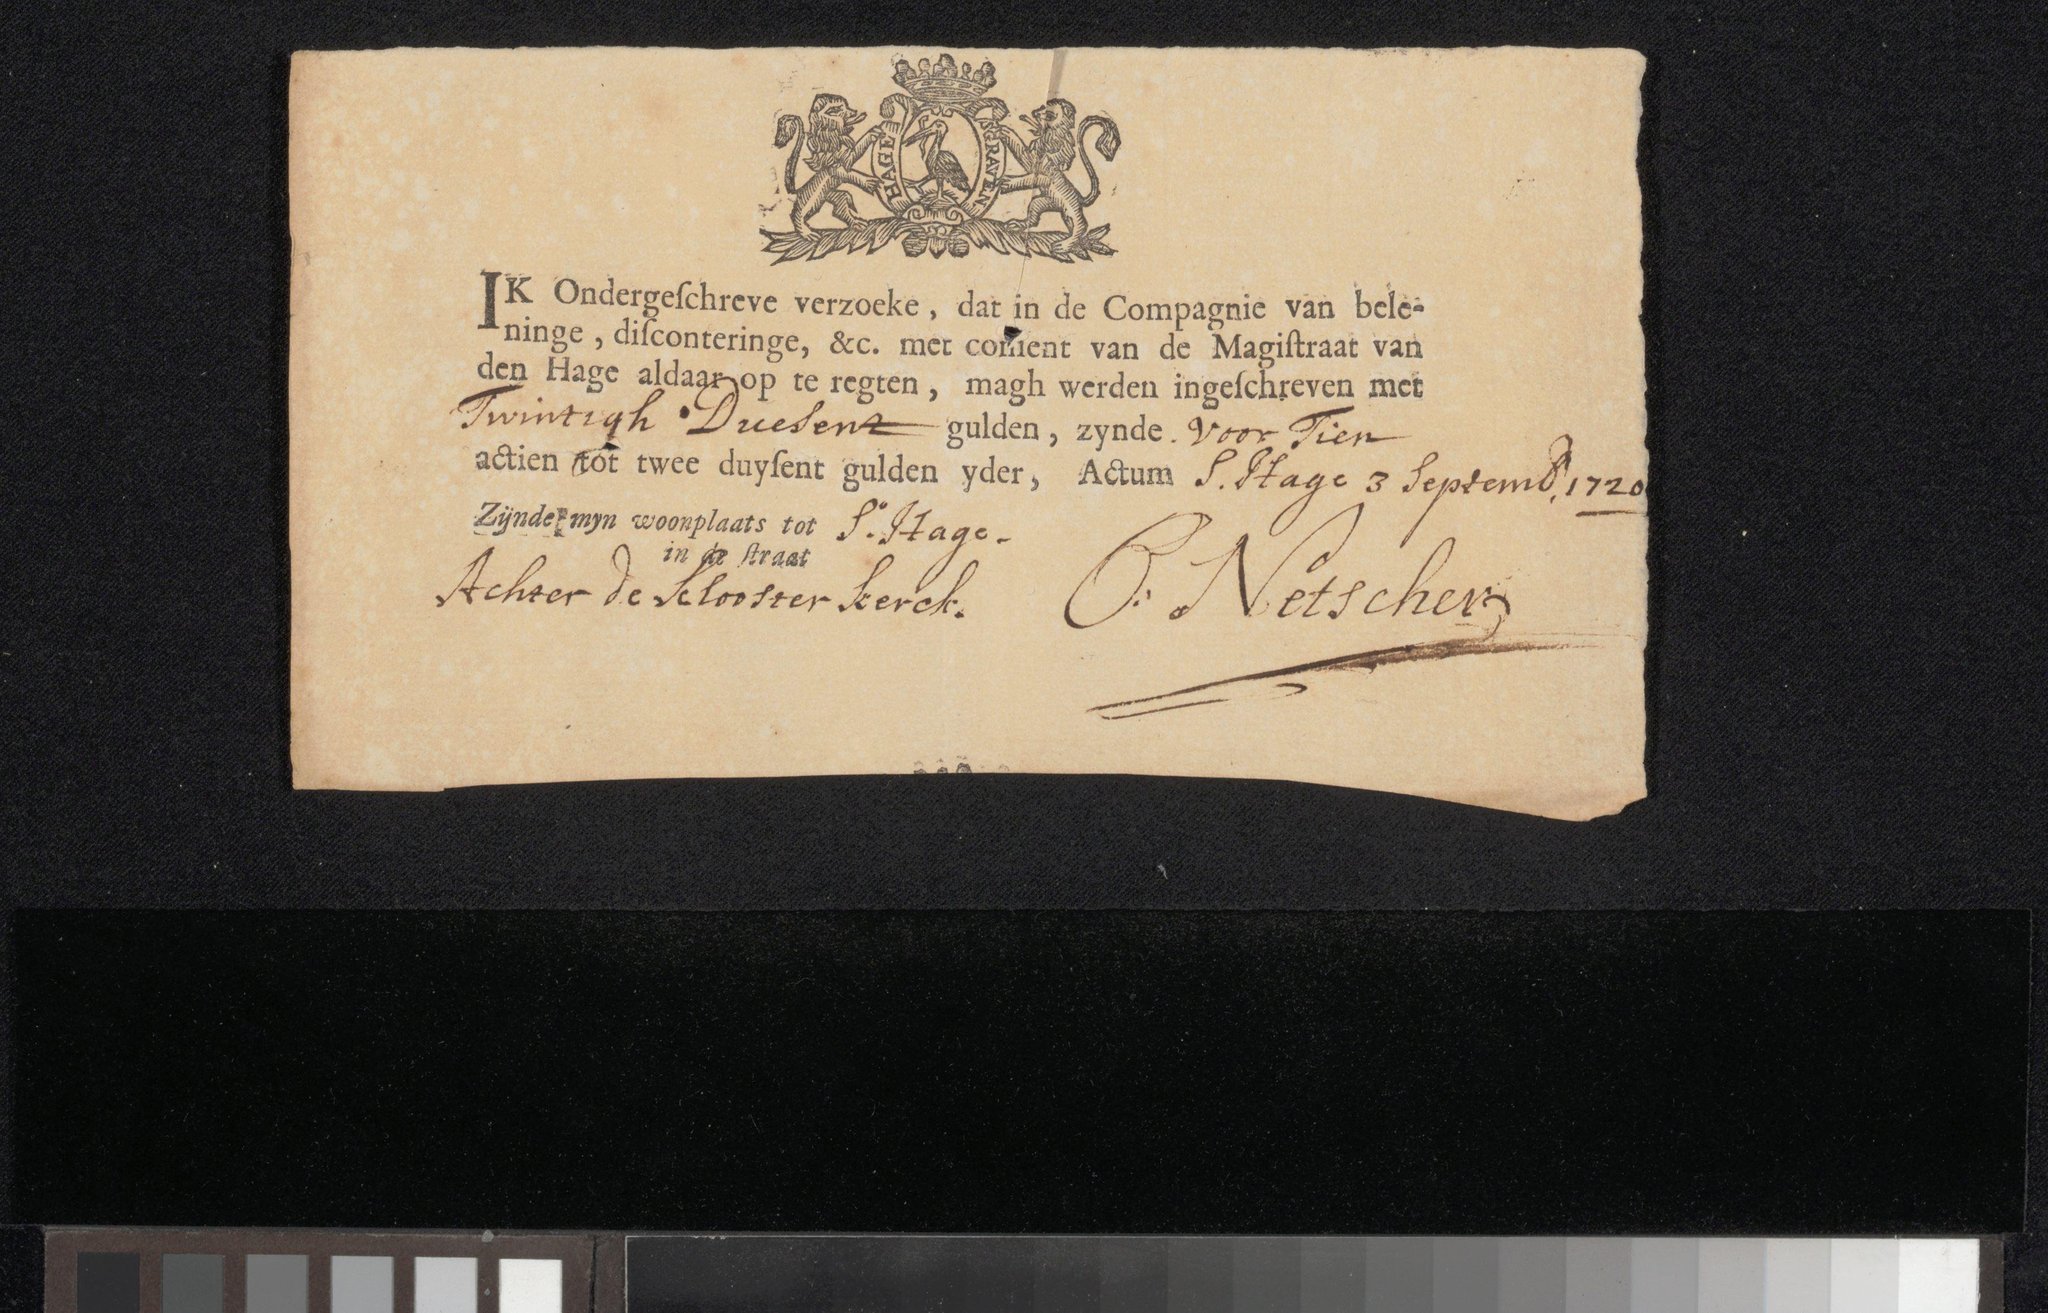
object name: document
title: Inschrijvingsbiljet van Constantijn Netscher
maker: constantijn netscher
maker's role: draughtsman, painter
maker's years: 1668-1723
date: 1720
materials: ink, paper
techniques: pen, printing, writing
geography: the hague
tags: money, the hague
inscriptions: collector's mark: Lugt 2233